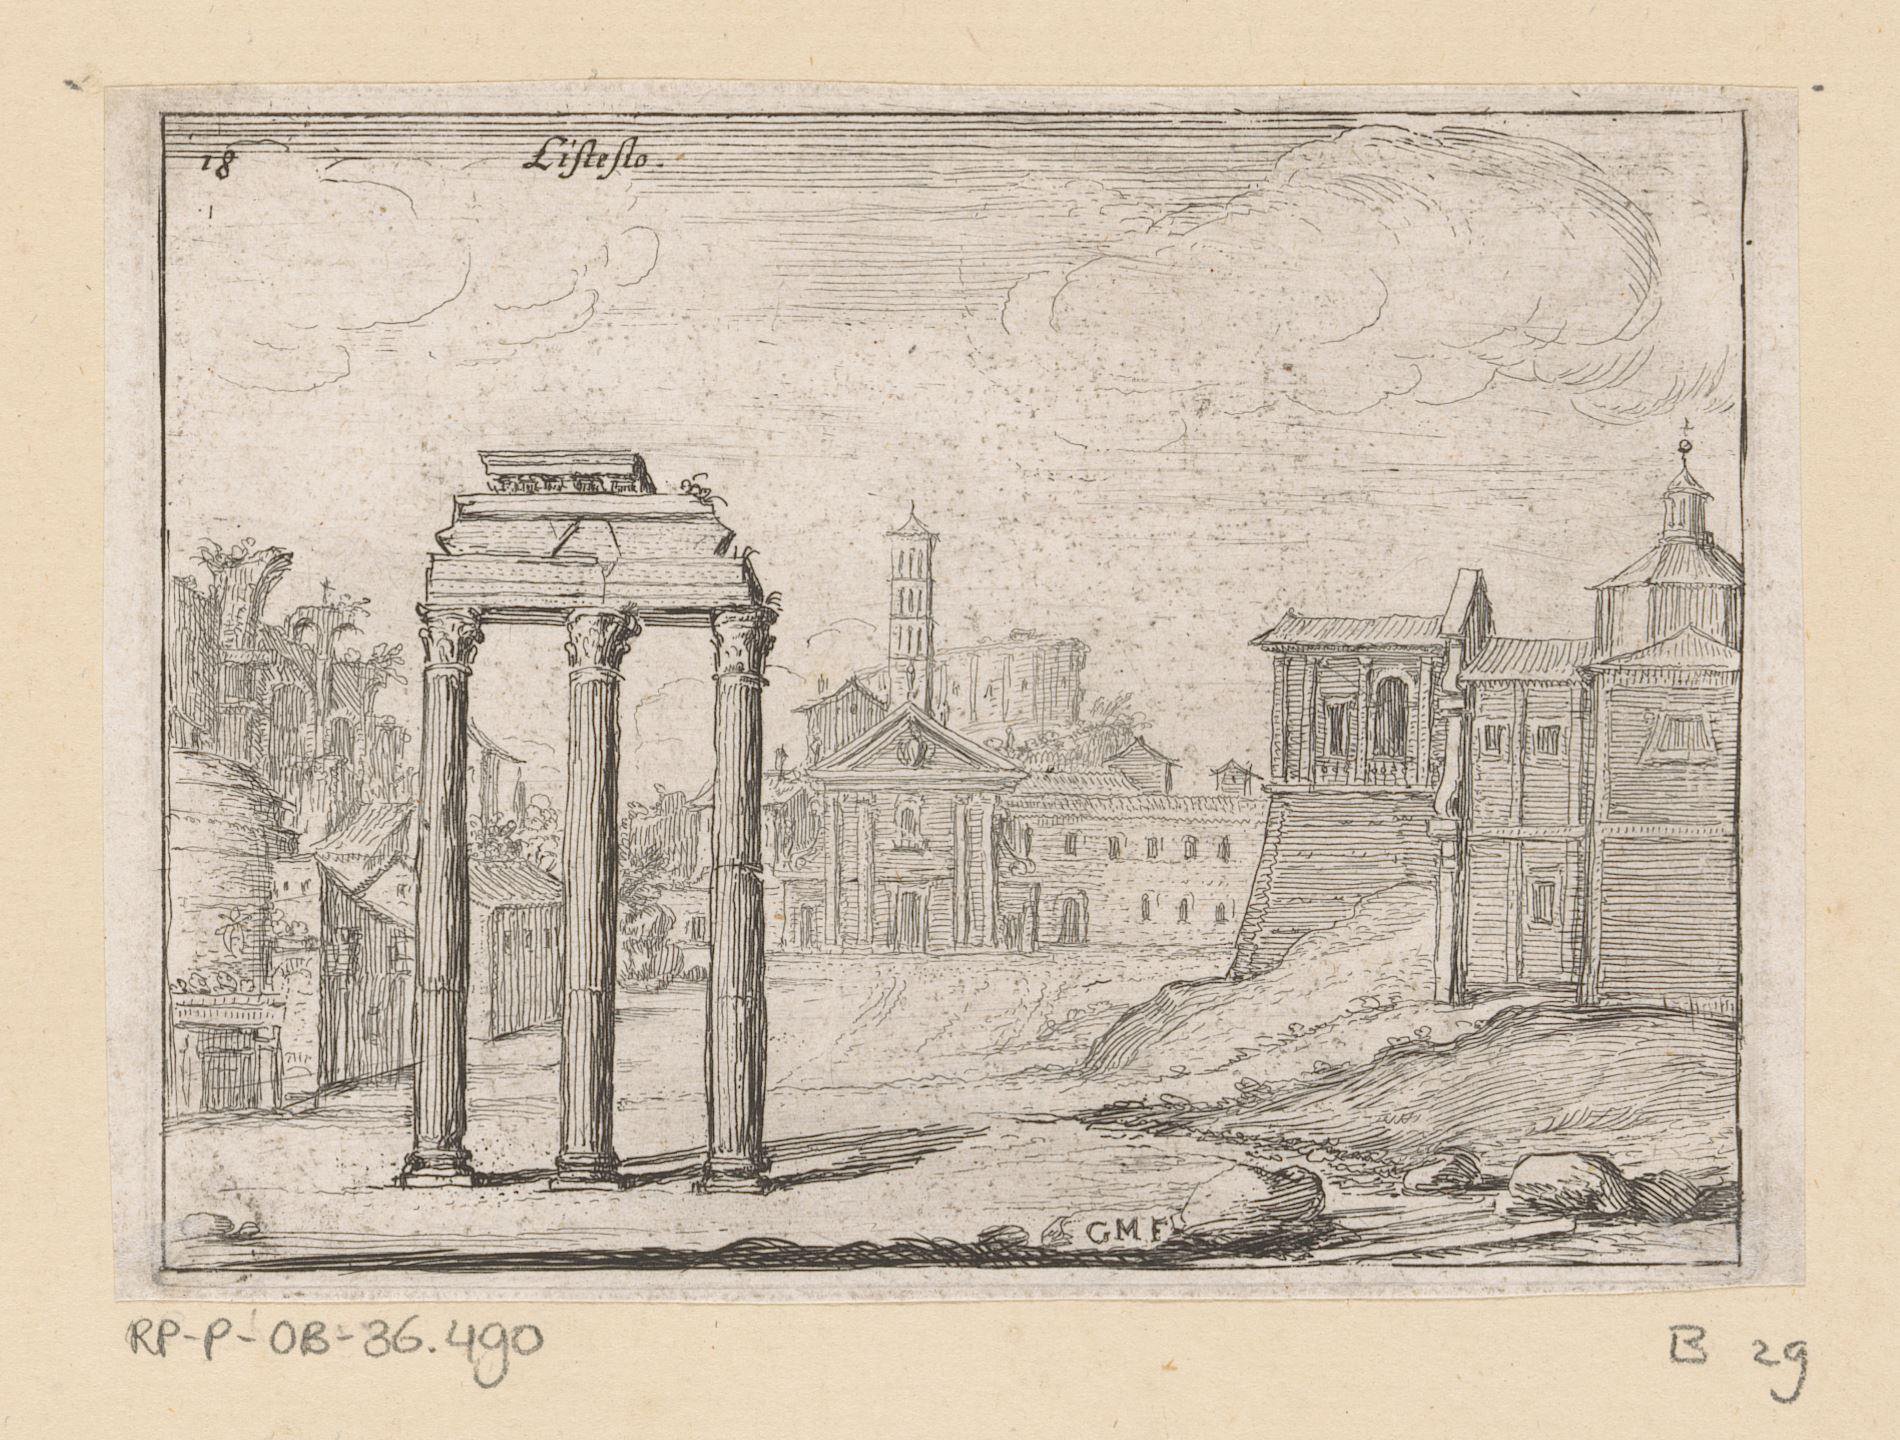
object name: print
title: Gezicht op het Forum Romanum te Rome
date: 1629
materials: paper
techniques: etching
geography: italy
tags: landscape with ruins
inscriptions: collector's mark: Lugt 2228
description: Deze prent maakt deel uit van een reeks van 52 prenten.